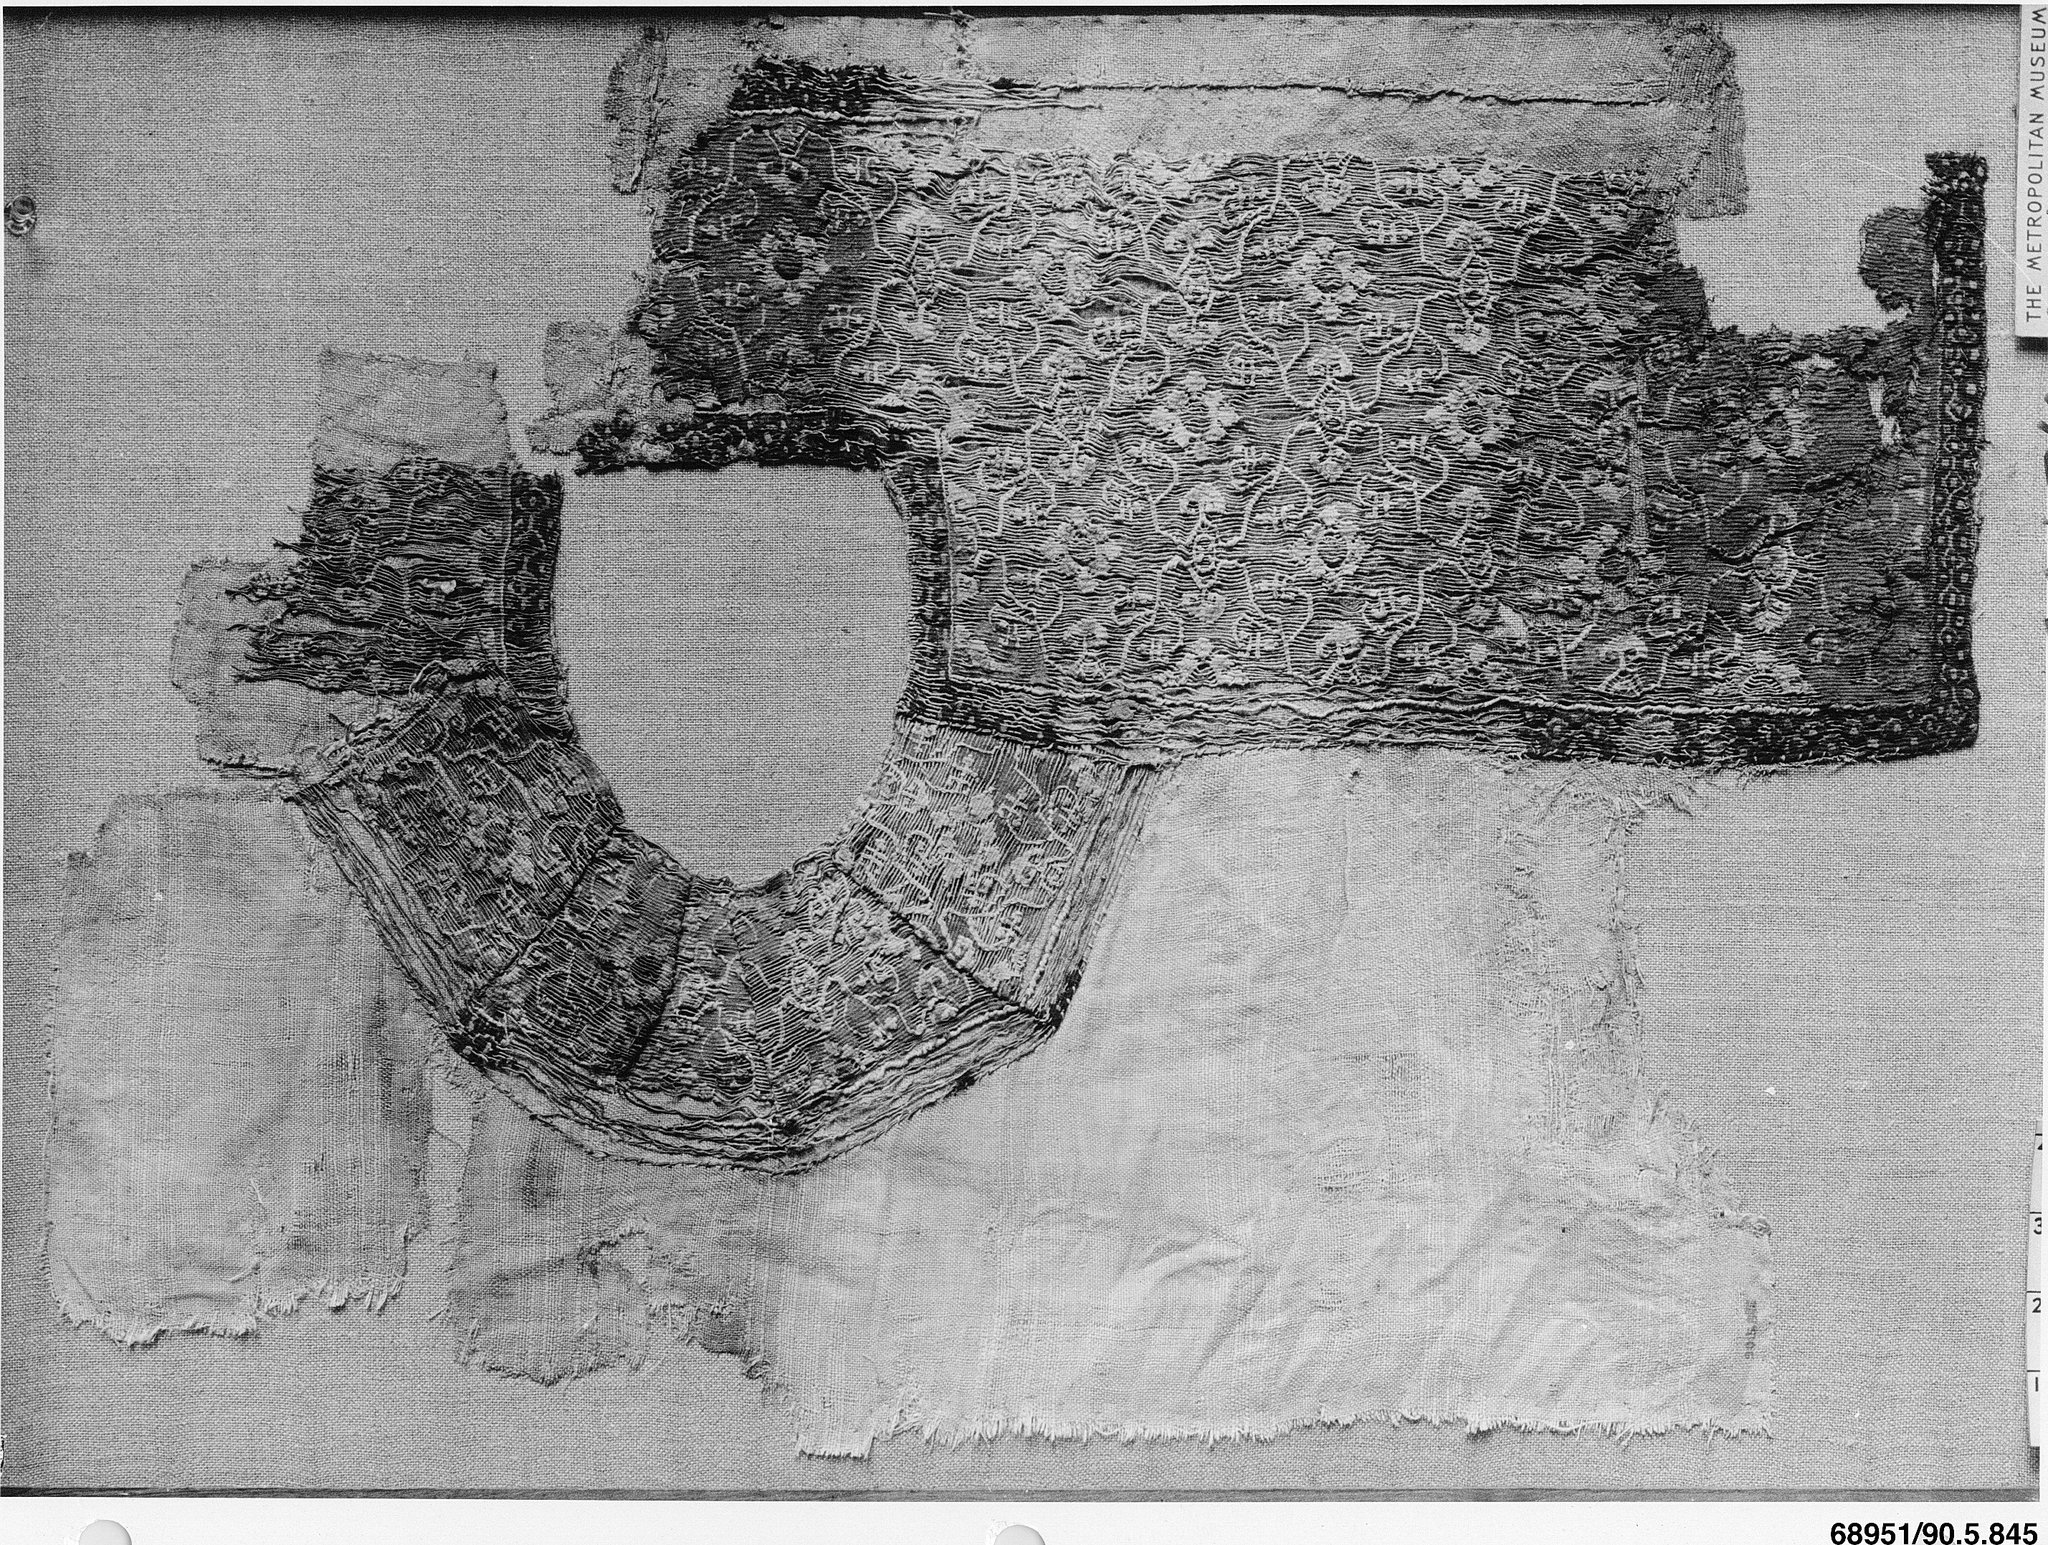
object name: tunic fragment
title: Fragment of a Tunic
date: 501-700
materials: linen, wool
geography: egypt